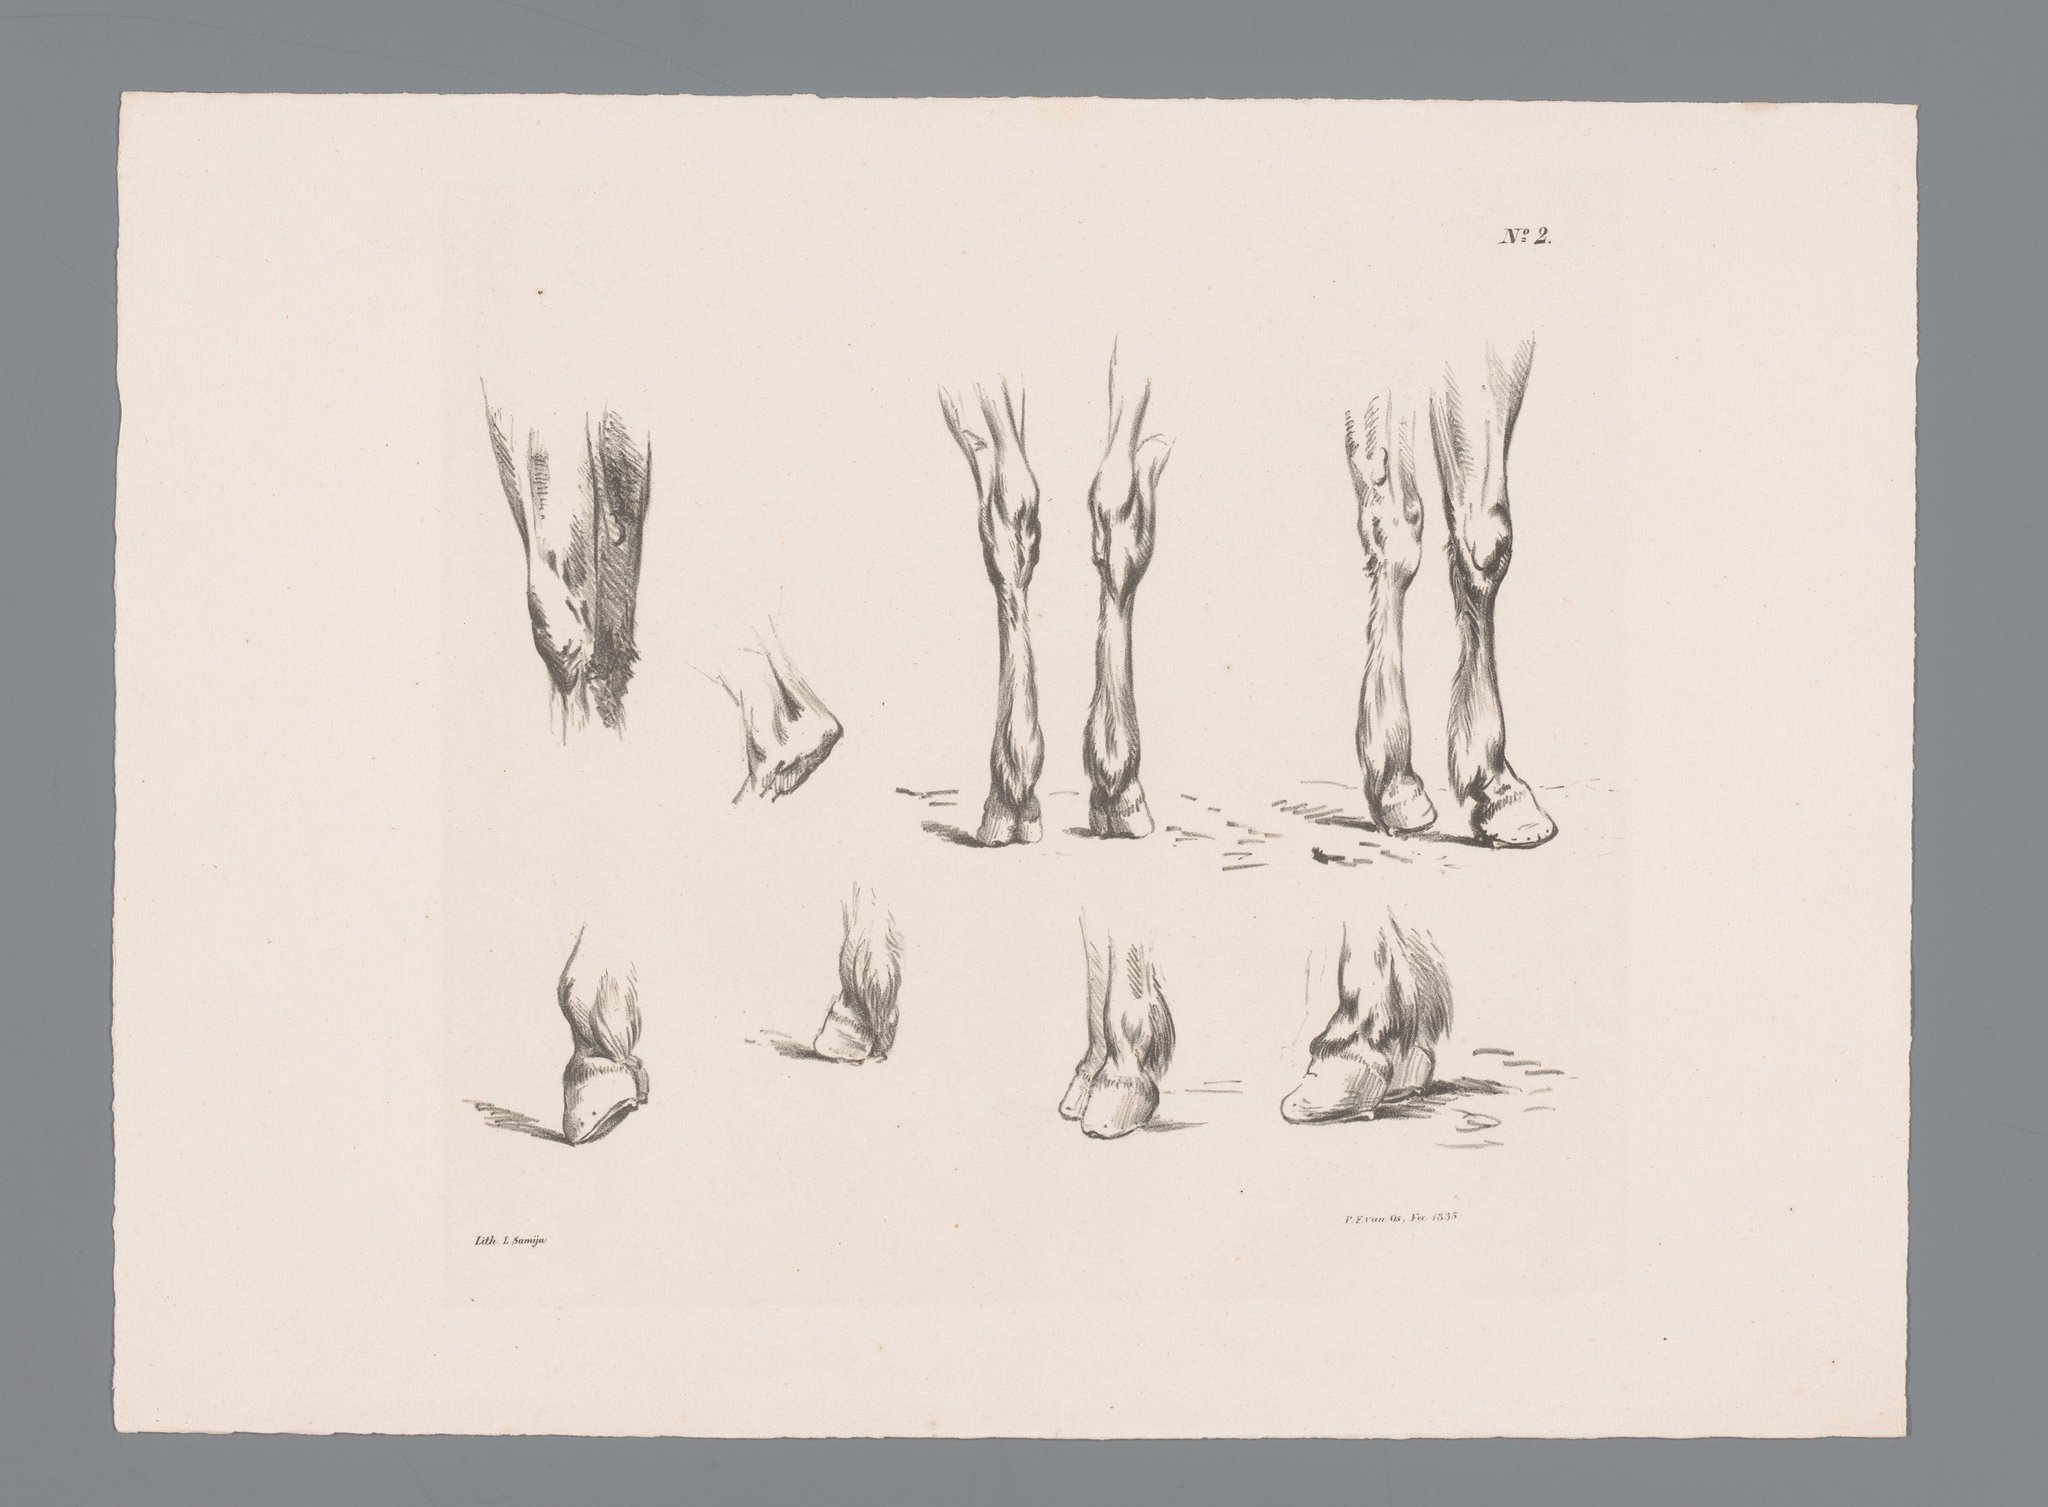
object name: print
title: Paarden Studien naar 't leven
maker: l. samijn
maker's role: printer, publisher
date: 1835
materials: paper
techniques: lithograph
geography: amsterdam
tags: animals (+ limbs of an animal), horse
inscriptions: collector's mark: Lugt 2228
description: Onderdeel van een omslag met een serie van tien paardenstudies.